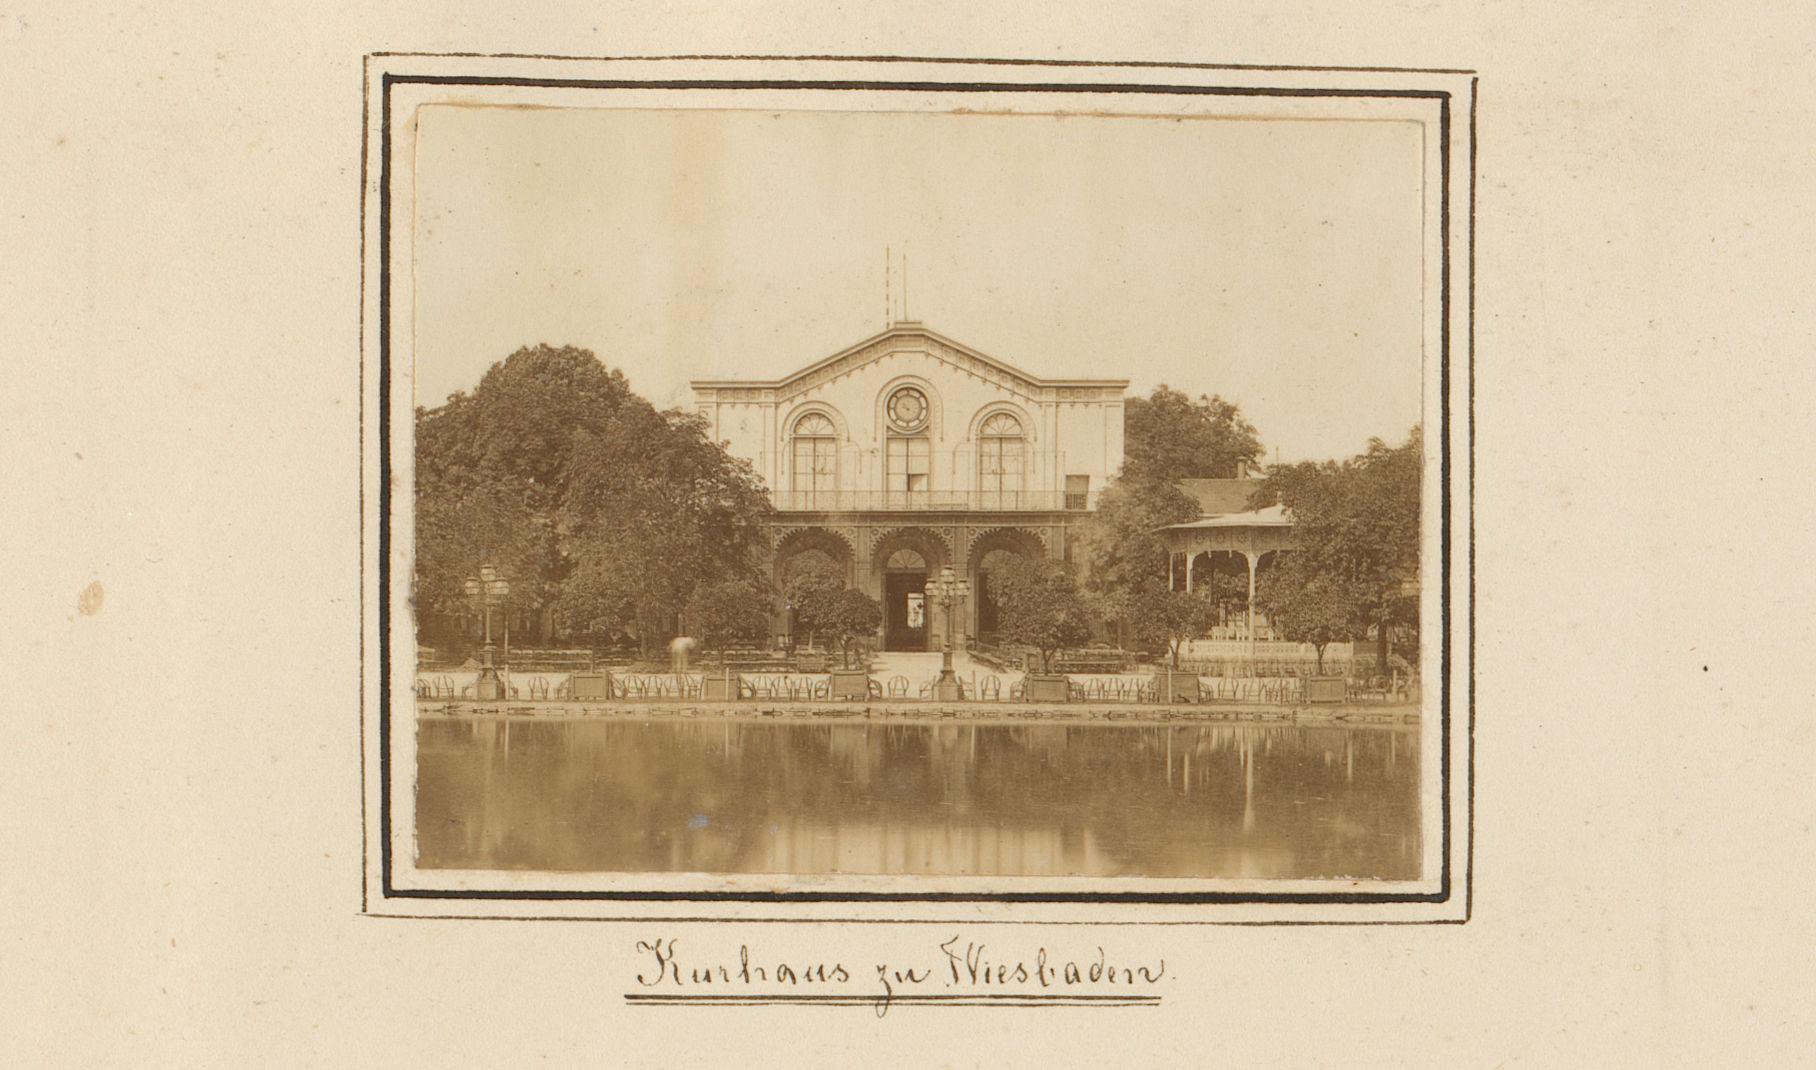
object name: album leaf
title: Kurhaus zu Wiesbaden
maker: Anonymous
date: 1870-1890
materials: paper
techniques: albumen print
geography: wiesbaden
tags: watering-place, spa